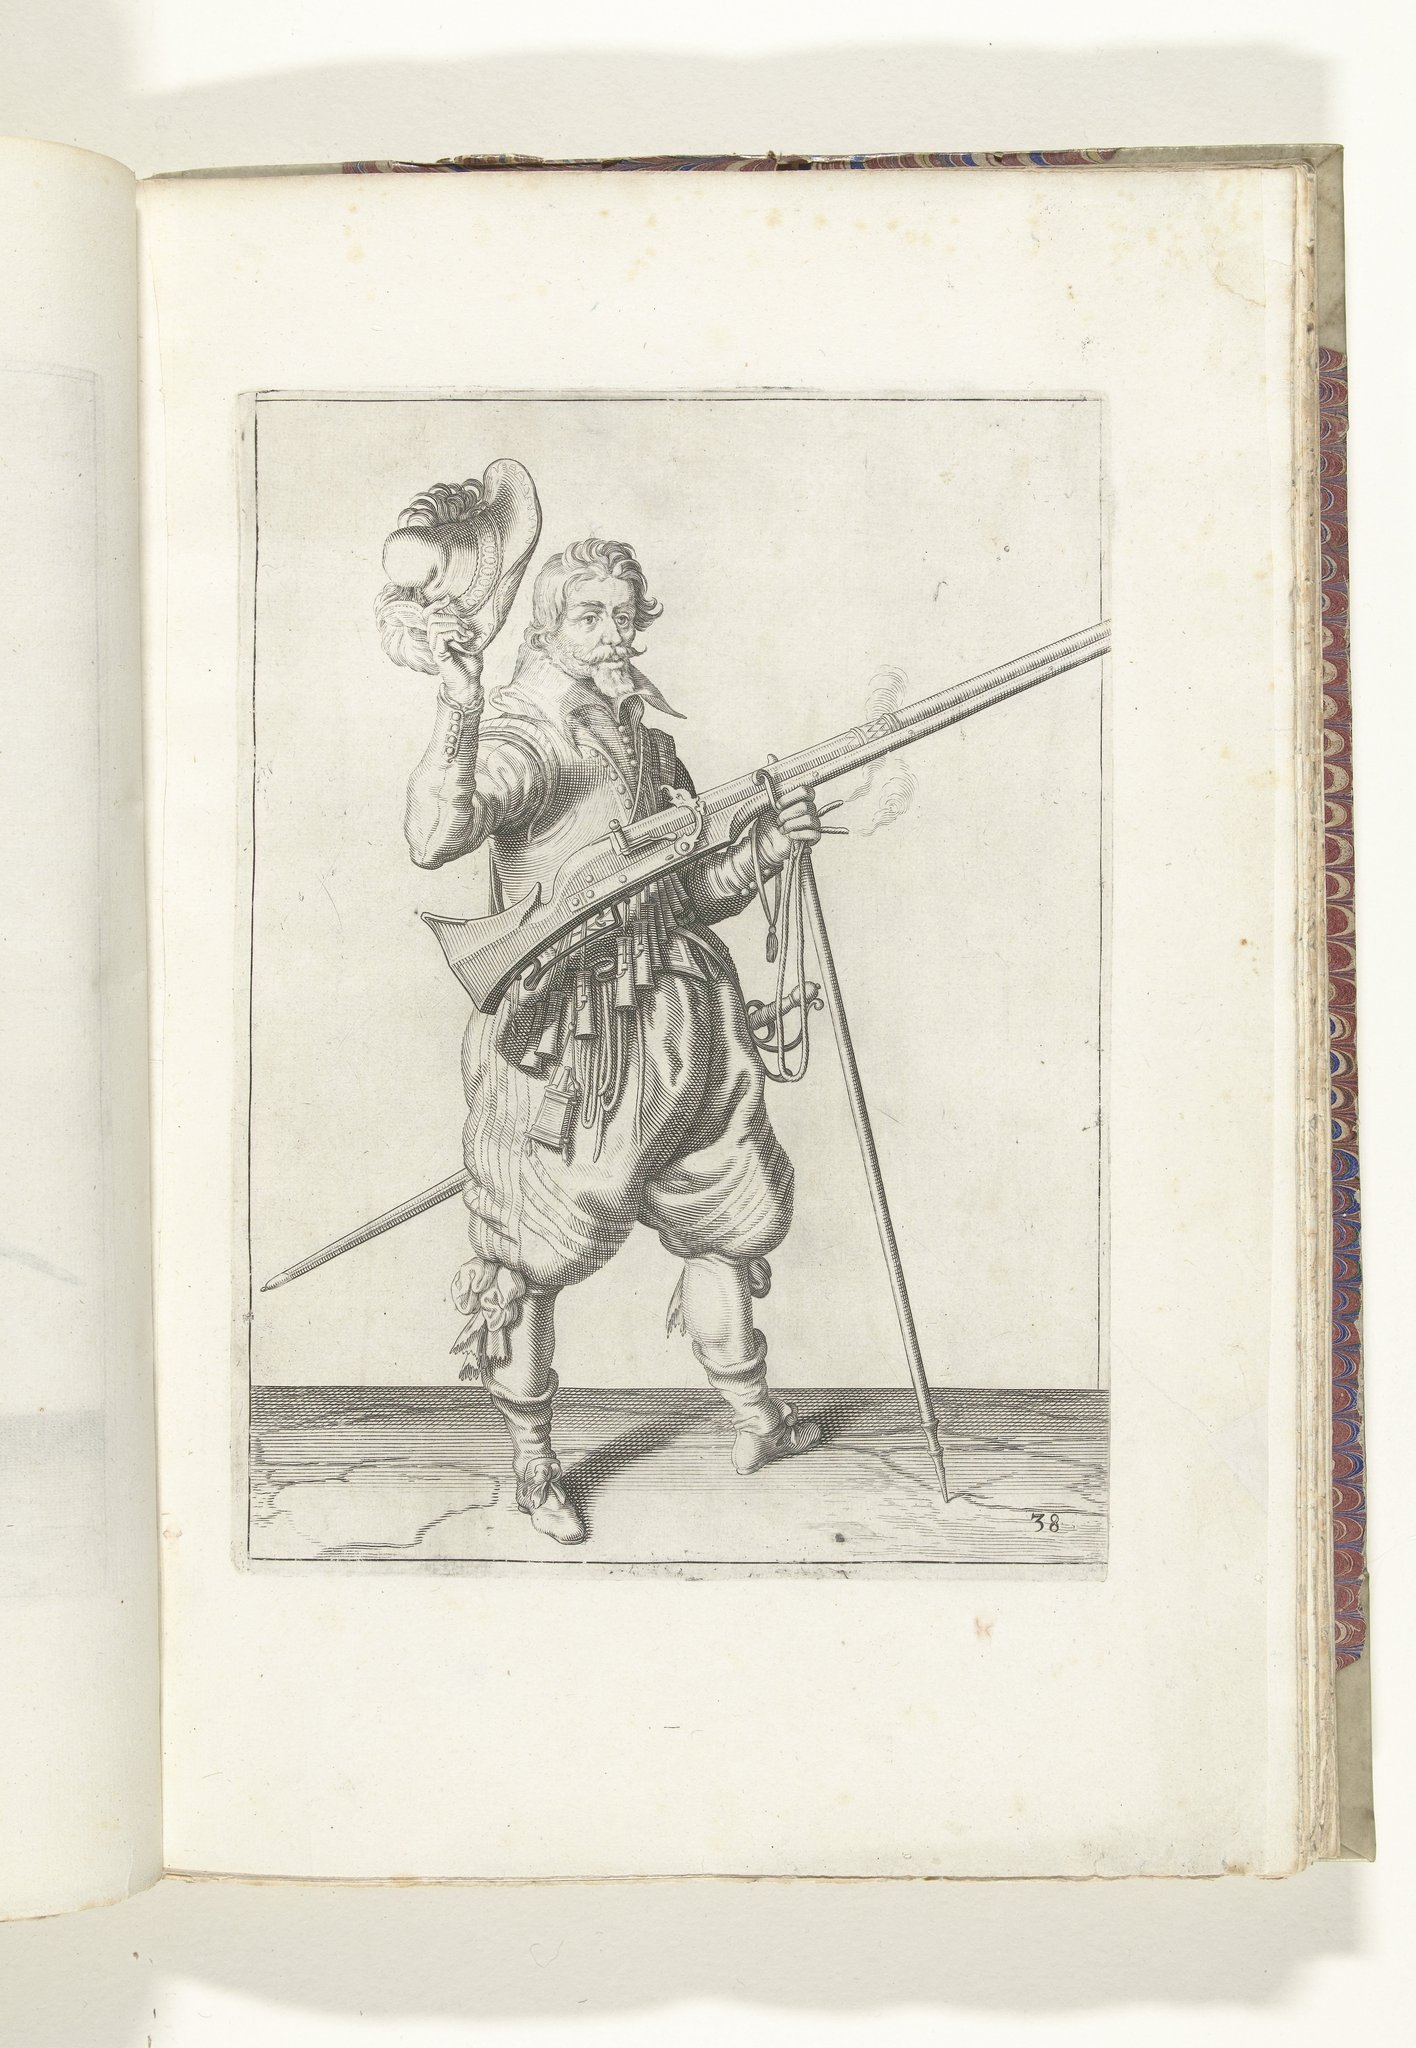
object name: print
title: Soldaat op wacht die zijn musket met zijn linkerhand bij zijn rechterzijde schuin omhoog gericht vasthoudt, terwijl hij met zijn rechterhand zijn hoed afneemt (nr. 38), ca. 1600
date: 1597-1607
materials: paper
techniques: engraving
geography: northern netherlands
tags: the hague, maurice (prince of orange), handling of weapons ~ military training, weapons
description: Een soldaat op wacht, ten voeten uit, naar rechts, die een musket (een bepaald type vuurwapen) bij zijn rechterzijde vasthoudt, zijn linkerhand om de vork van het furket (musketvork) waarop de loop, schuin omhoog gericht, rust (nr. 38), ca. 1600. In zijn linkerhand tevens een brandende lont. Met zijn rechterhand neemt de soldaat zijn hoed af. Plaat 38 in de instructies voor het hanteren van het musket: Corte onderrechtinghe op de figuerlicke afbeeldinghe, soo veel aengaet het recht ghebruyck van Musquet. Onderdeel van de illustraties in: J. de Gheyn, Wapenhandelinghe van Roers Musquetten ende spiessen, Amsterdam, 1608. Krijgswezen rond 1600.